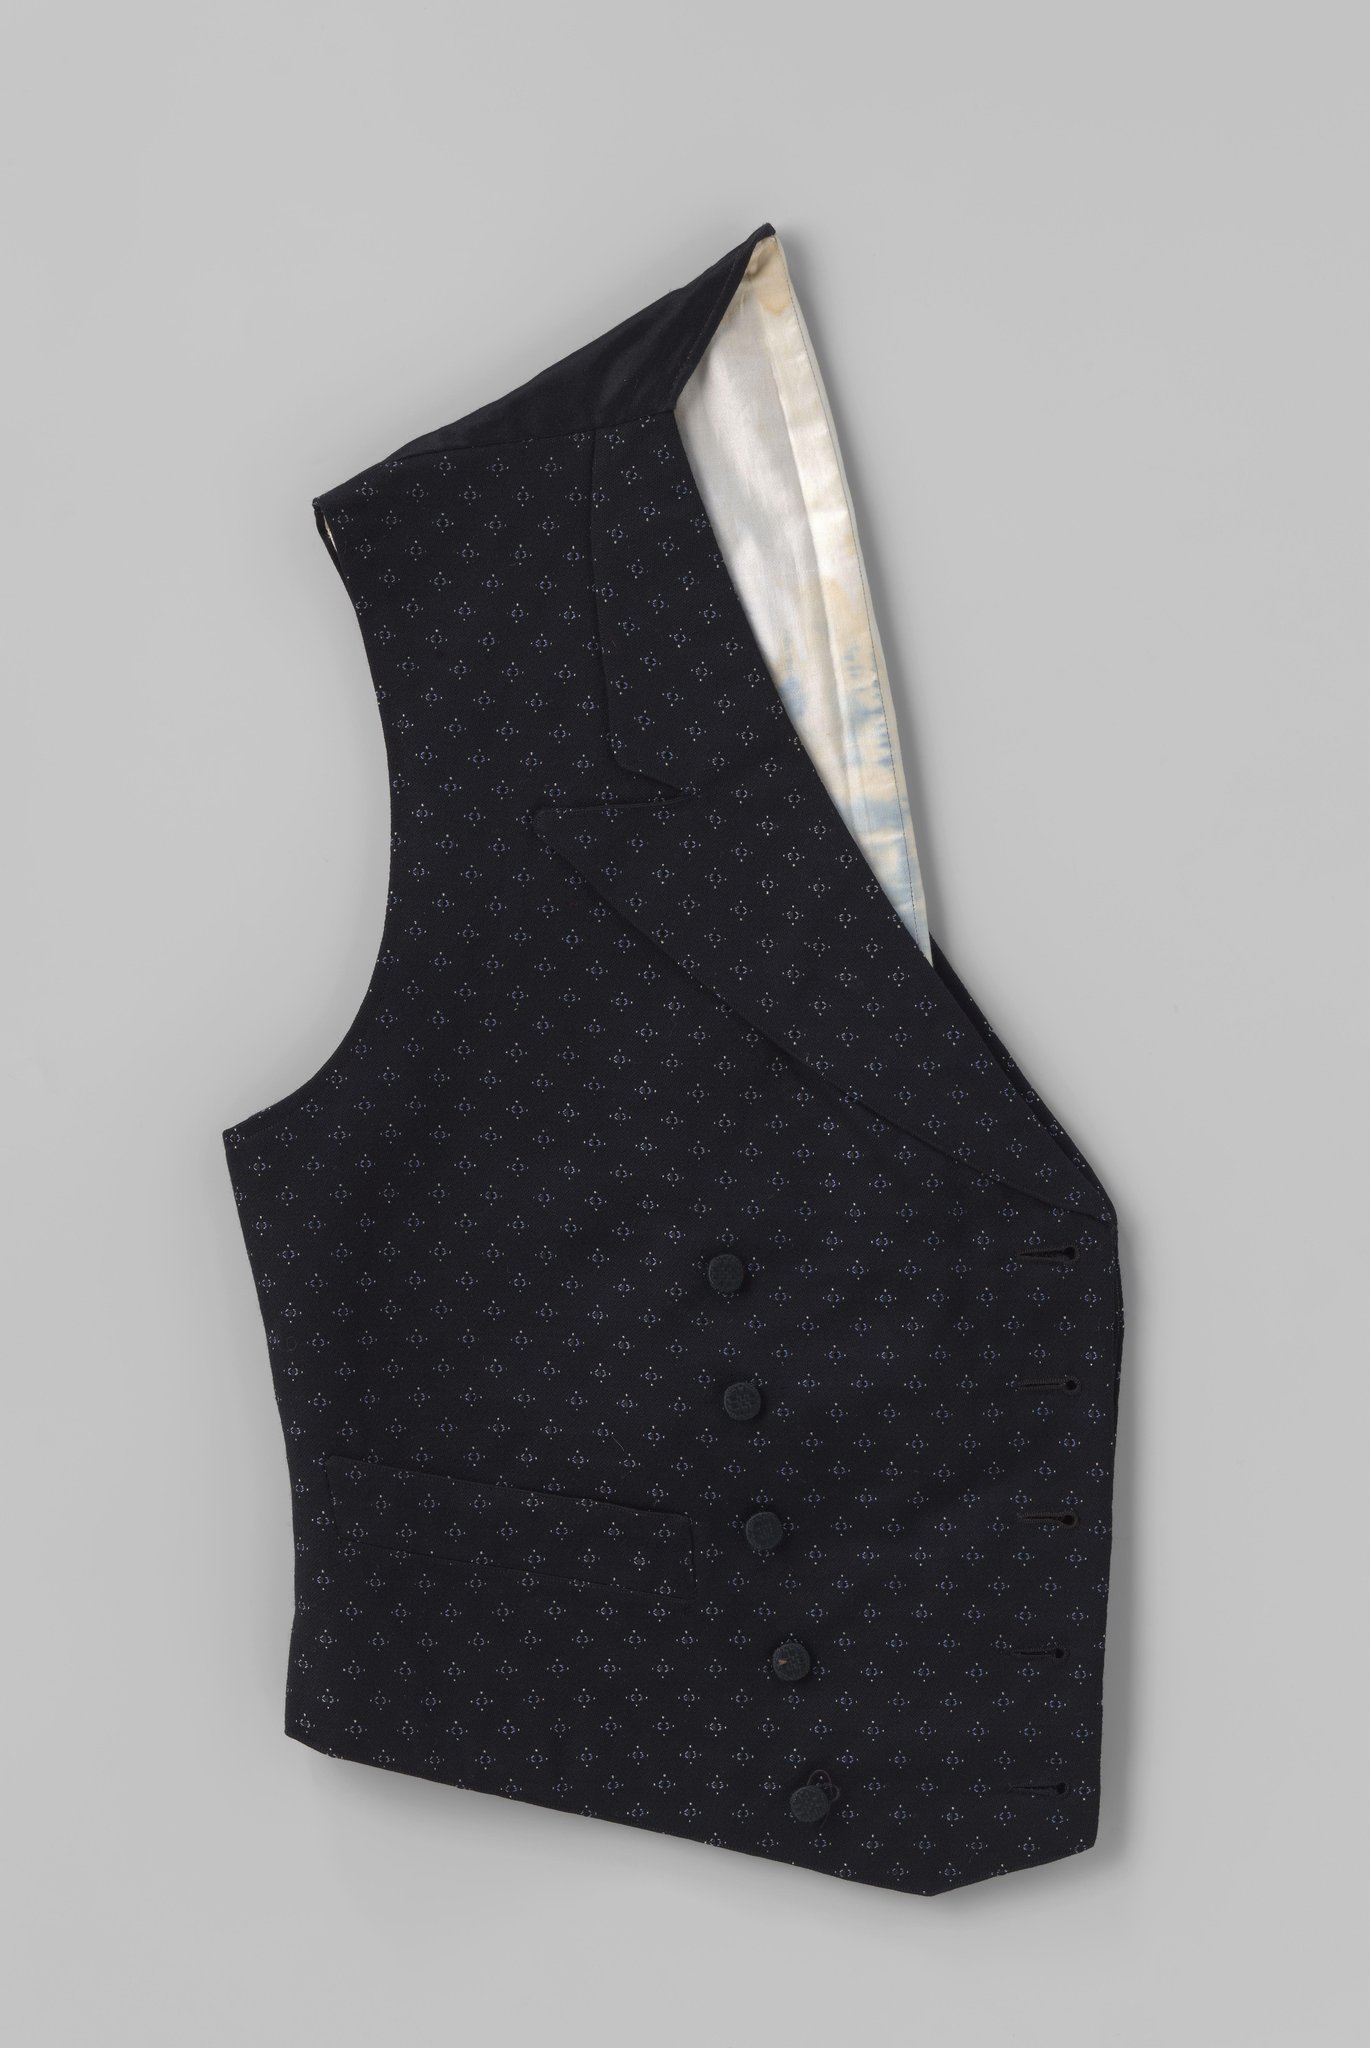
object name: menswear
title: Wintervest van wol, zwart met blauwe figuurtjes met witte stipjes, kort model, de voorpanden van onder in een boog gesneden en met overslag met dubbele rij zwarte passementknoopjes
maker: Anonymous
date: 1905-1910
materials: wool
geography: brussels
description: Wintervest van wol, zwart met blauwe figuurtjes met witte stipjes. Kort model vest, de voorpanden van onder in een boog gesneden en met overslag met dubbele rij zwarte passementknoopjes. Liggende kraag met brede puntrevers. Twee insteekzakken en een kleiner horlogezakje, alle met aangenaaide pas verstevigd. Rug van zwart satinet met riempjes met gesp. Voor en achter met wit satinet gevoerd, waarin aan de linkerkant een binnenzak met knoopje.